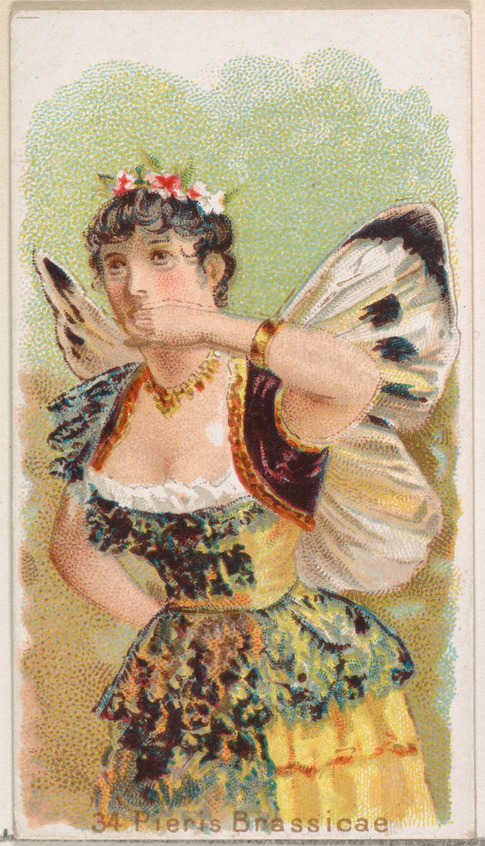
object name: print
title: Card 34, Pieris Brassicae, from the Butterflies series (N183) issued by Wm. S. Kimball & Co.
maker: william s. kimball & company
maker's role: publisher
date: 1888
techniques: color lithograph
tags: women,butterflies